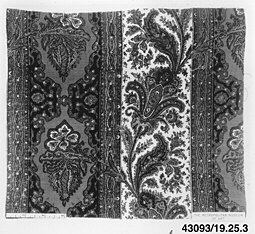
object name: sample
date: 1830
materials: wool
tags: flowers